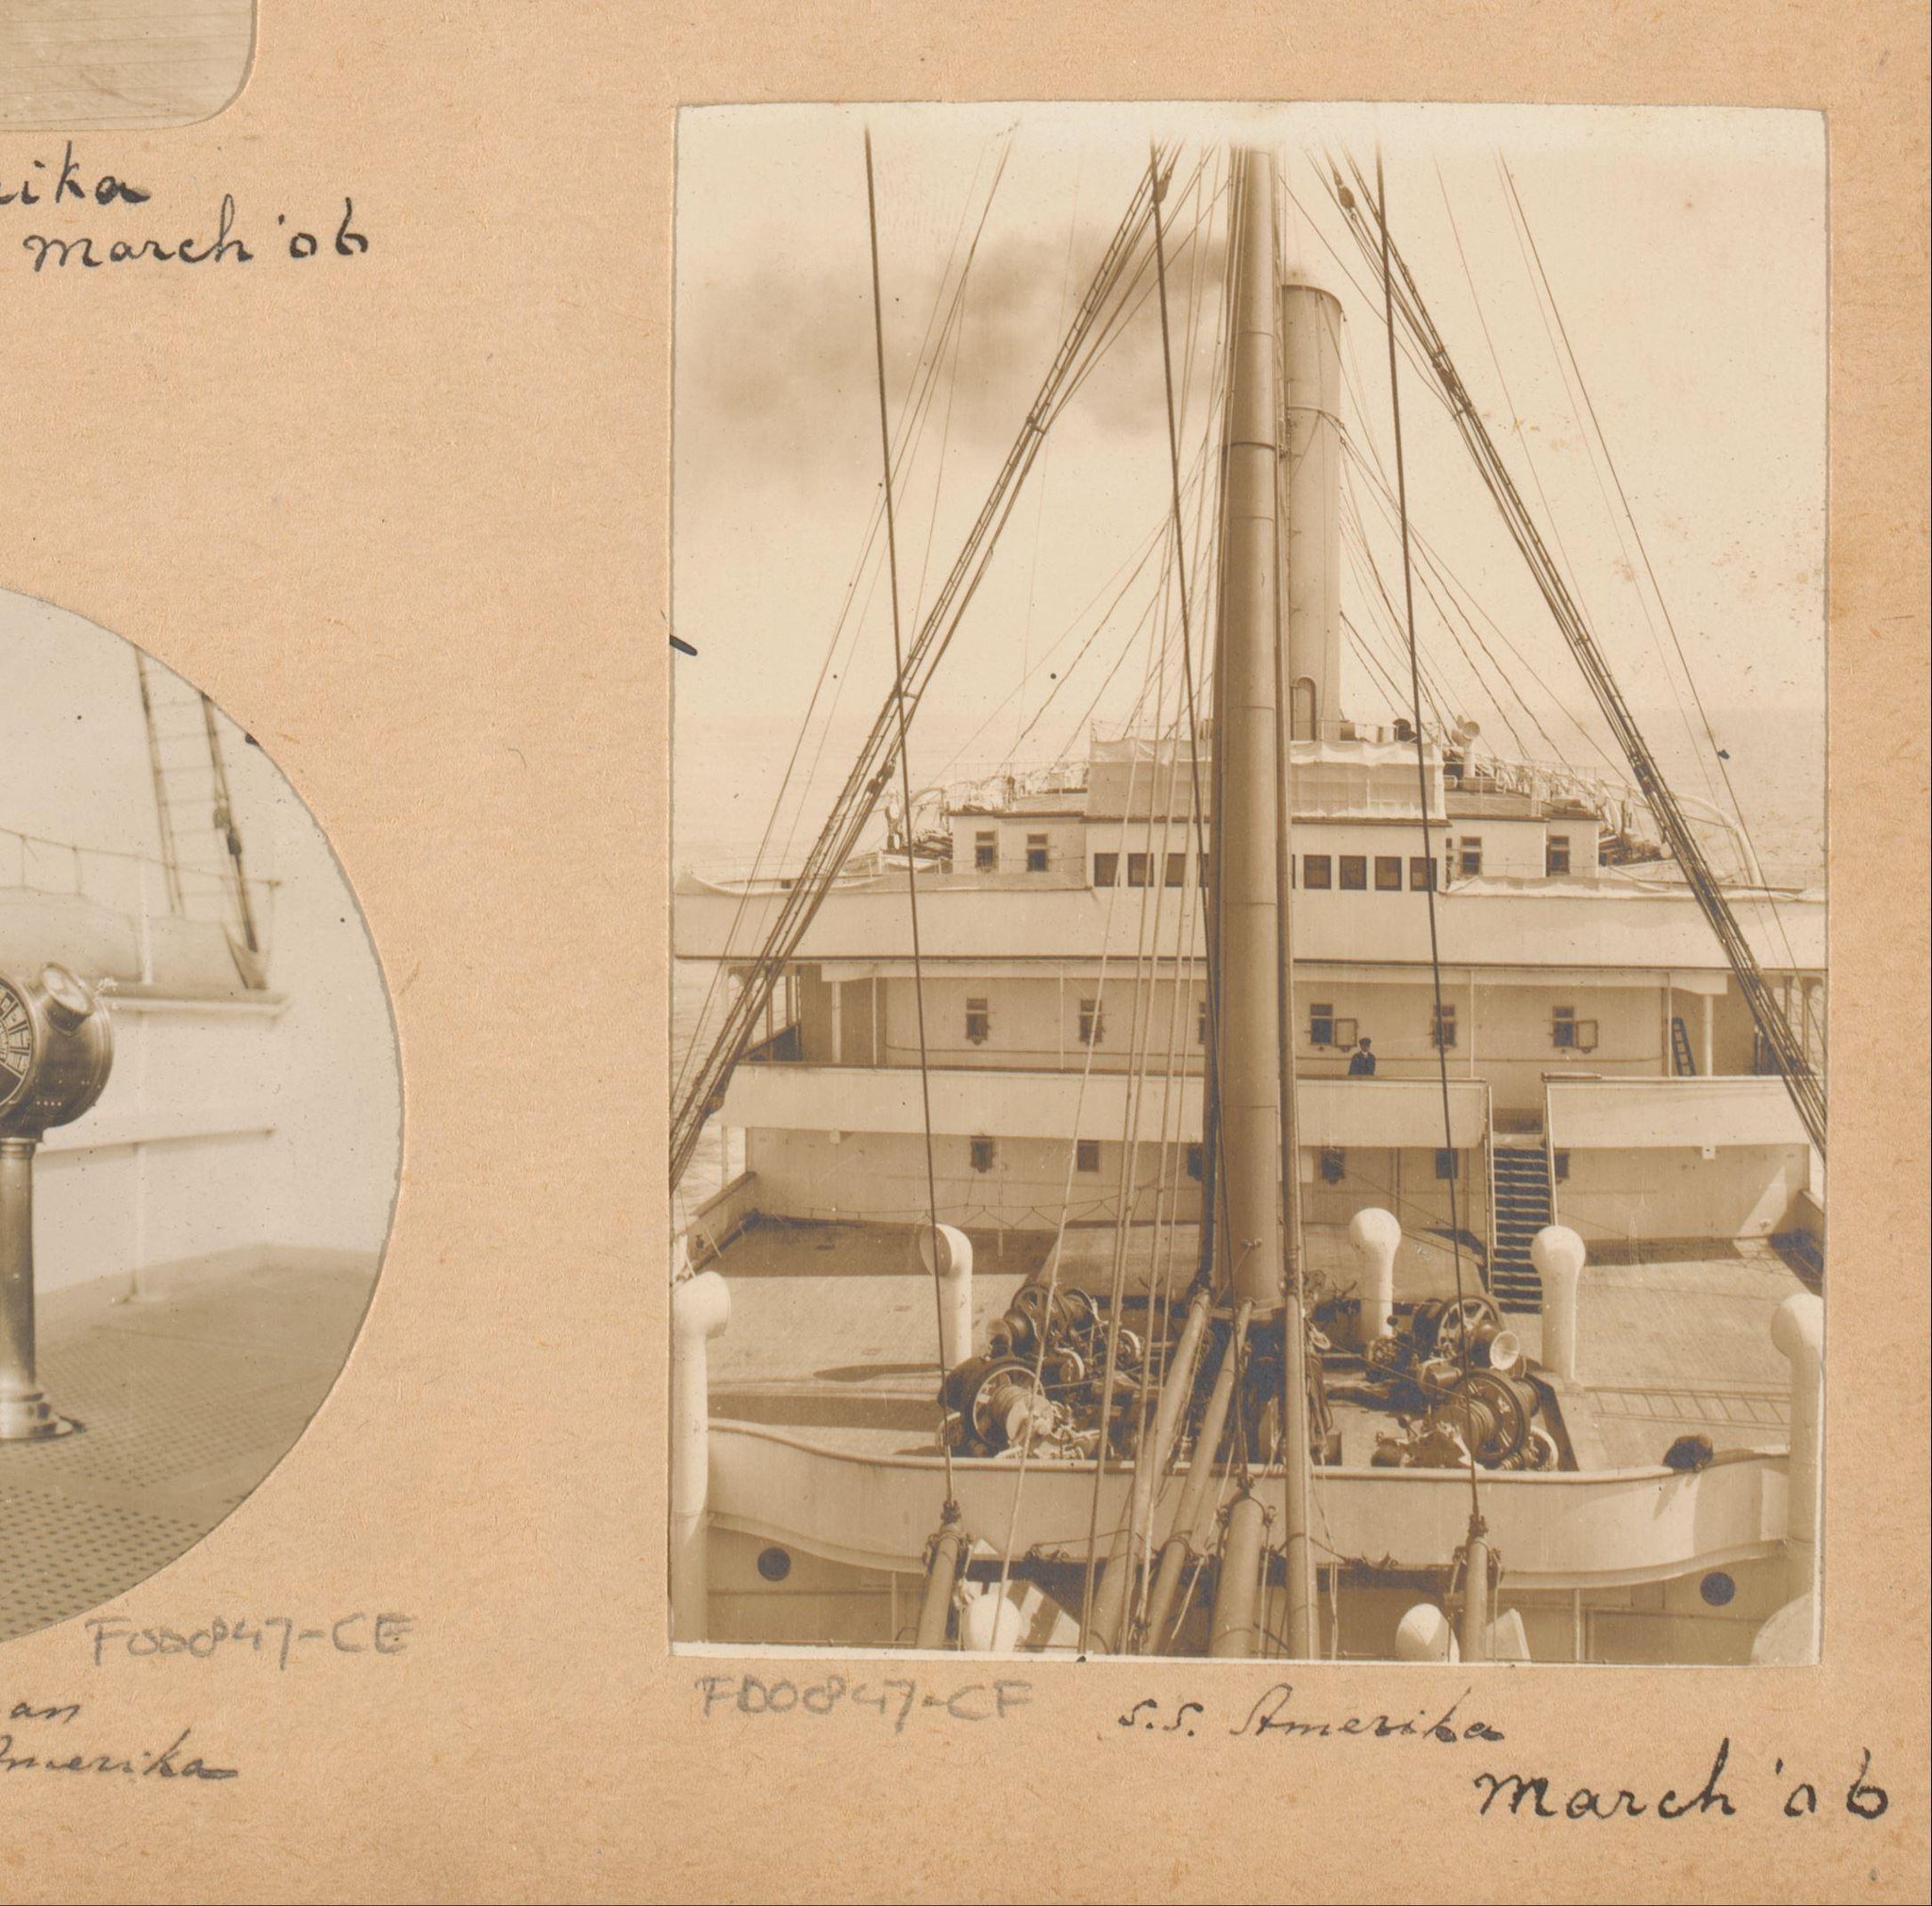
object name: album leaf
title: Gezicht op de dekken, cabines en een mast van de SS Amerika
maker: Anonymous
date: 1903-1906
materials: cardboard, paper, photographic support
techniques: gelatin silver print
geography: atlantic ocean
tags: freight vessel, parts of ship's exterior: deck, parts of ship's exterior: mast, steamship, motorship, atlantic ocean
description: Onderdeel van Reisalbum van een Nederlandse familie met bezienswaardigheden in Europa, Egypte en New York.